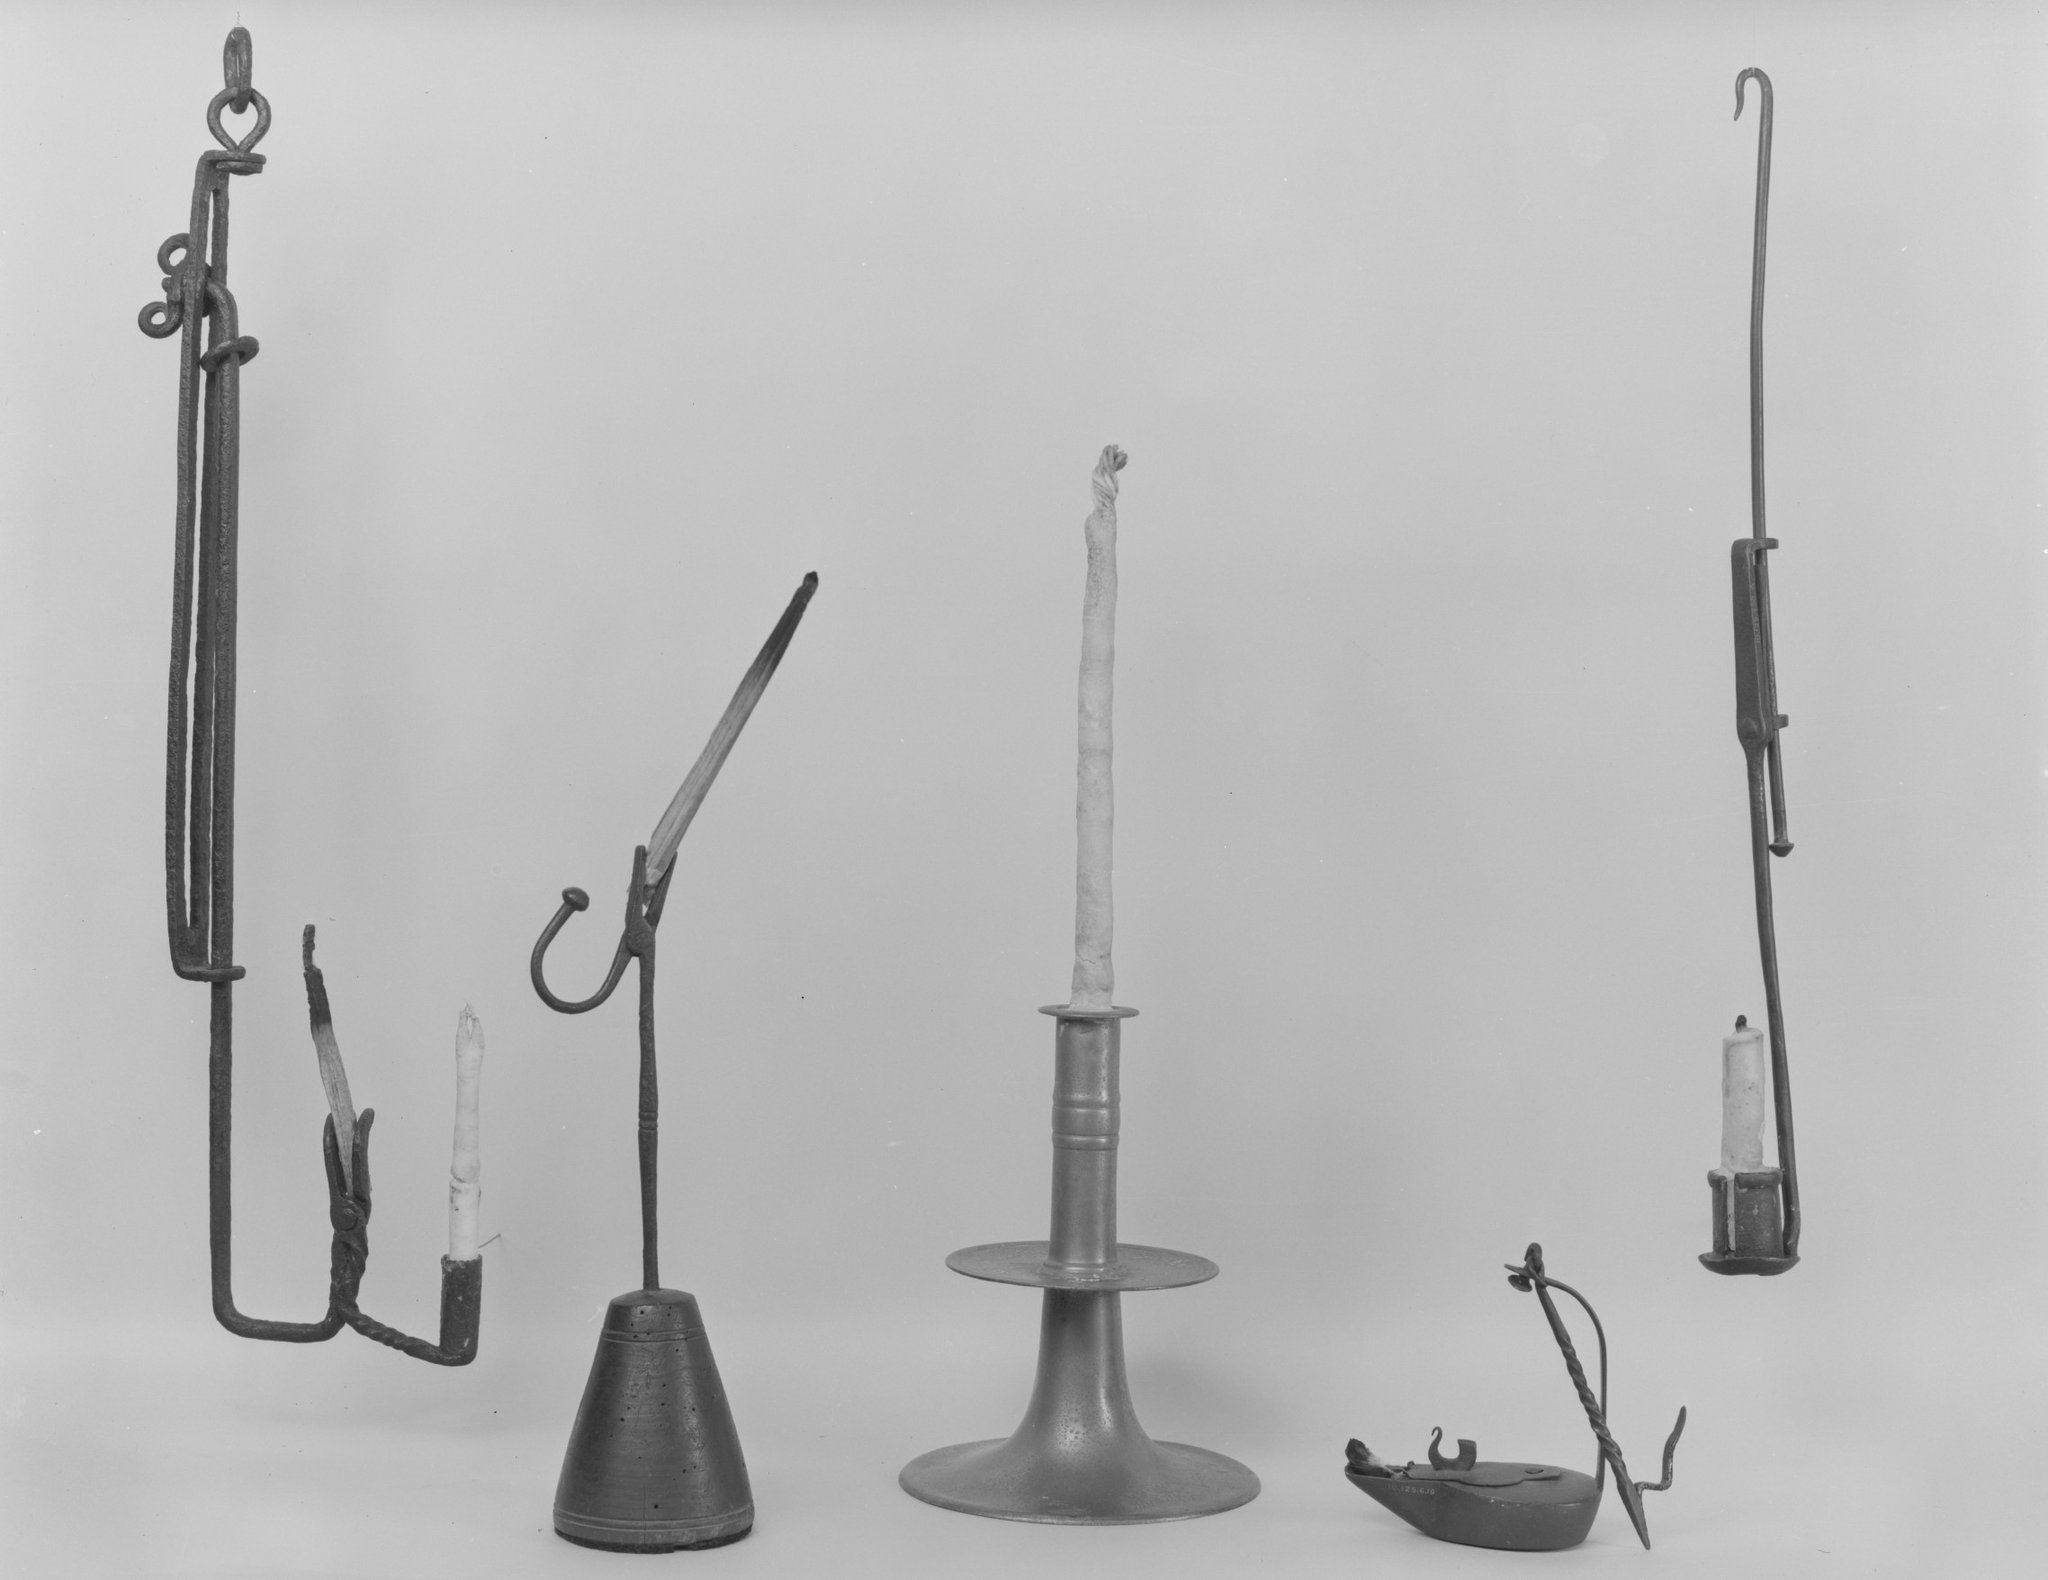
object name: candlestick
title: Hanging Candlestick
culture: american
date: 1600-1800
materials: iron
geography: united states